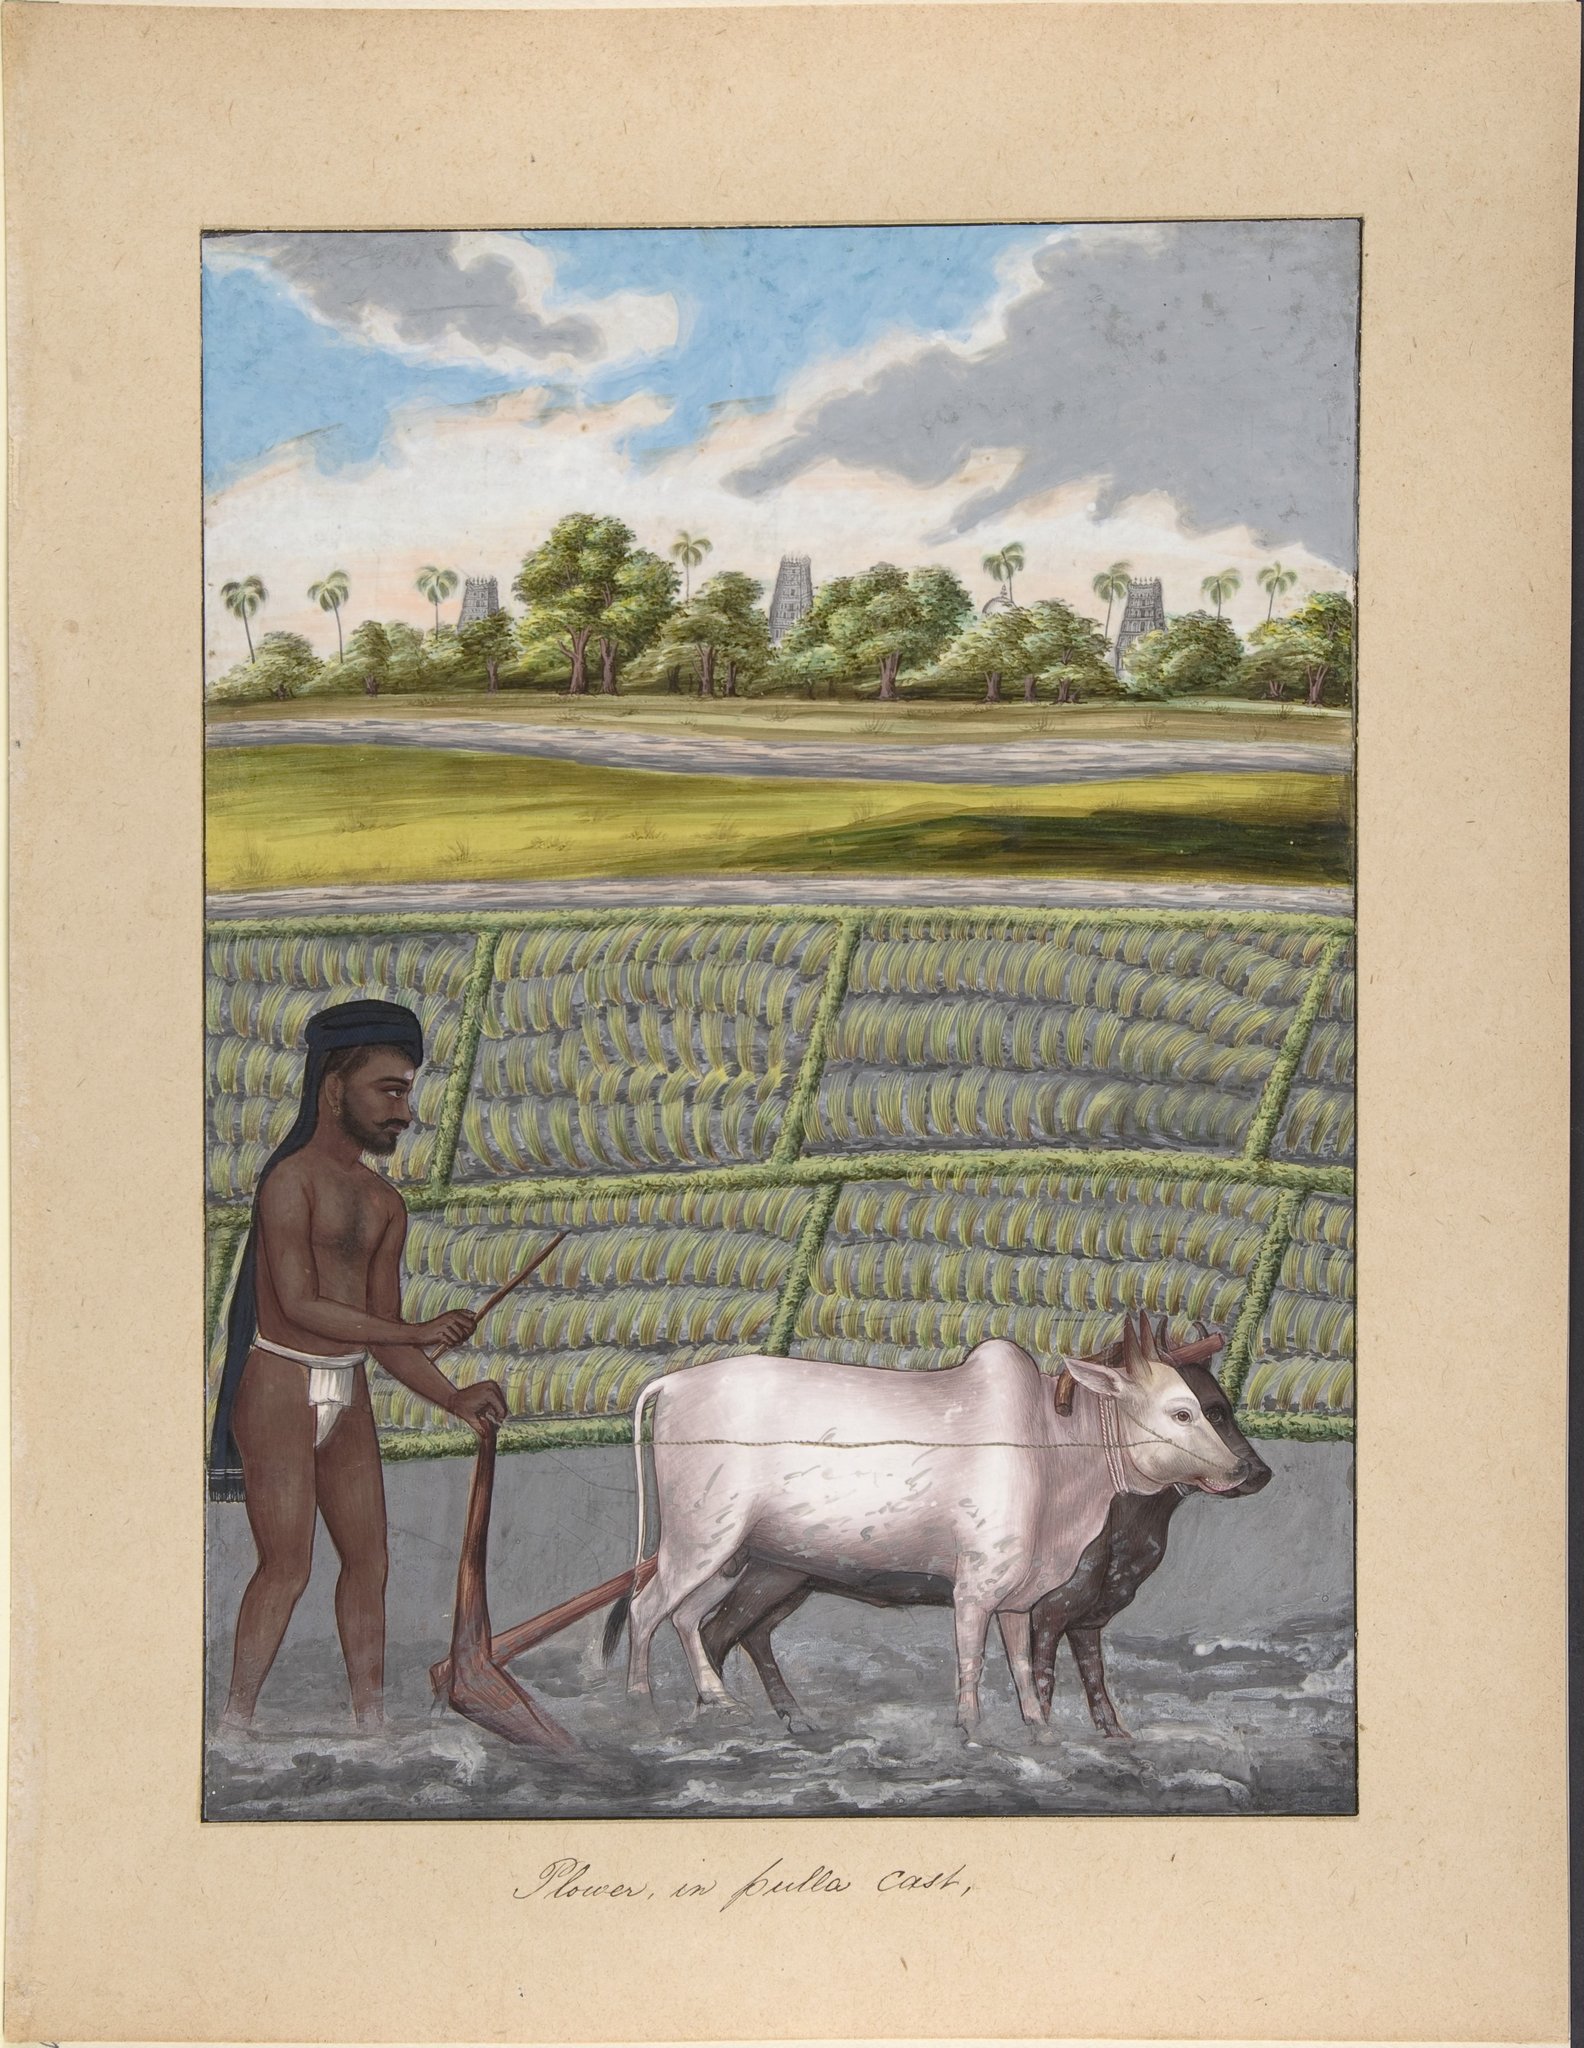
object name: drawing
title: Plower in Pulla Caste, from Indian Trades and Castes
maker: anonymous, indian, 19th century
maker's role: artist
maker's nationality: indian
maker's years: 1800-1900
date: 1840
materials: gouache, watercolor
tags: farms,men,agriculture,cows